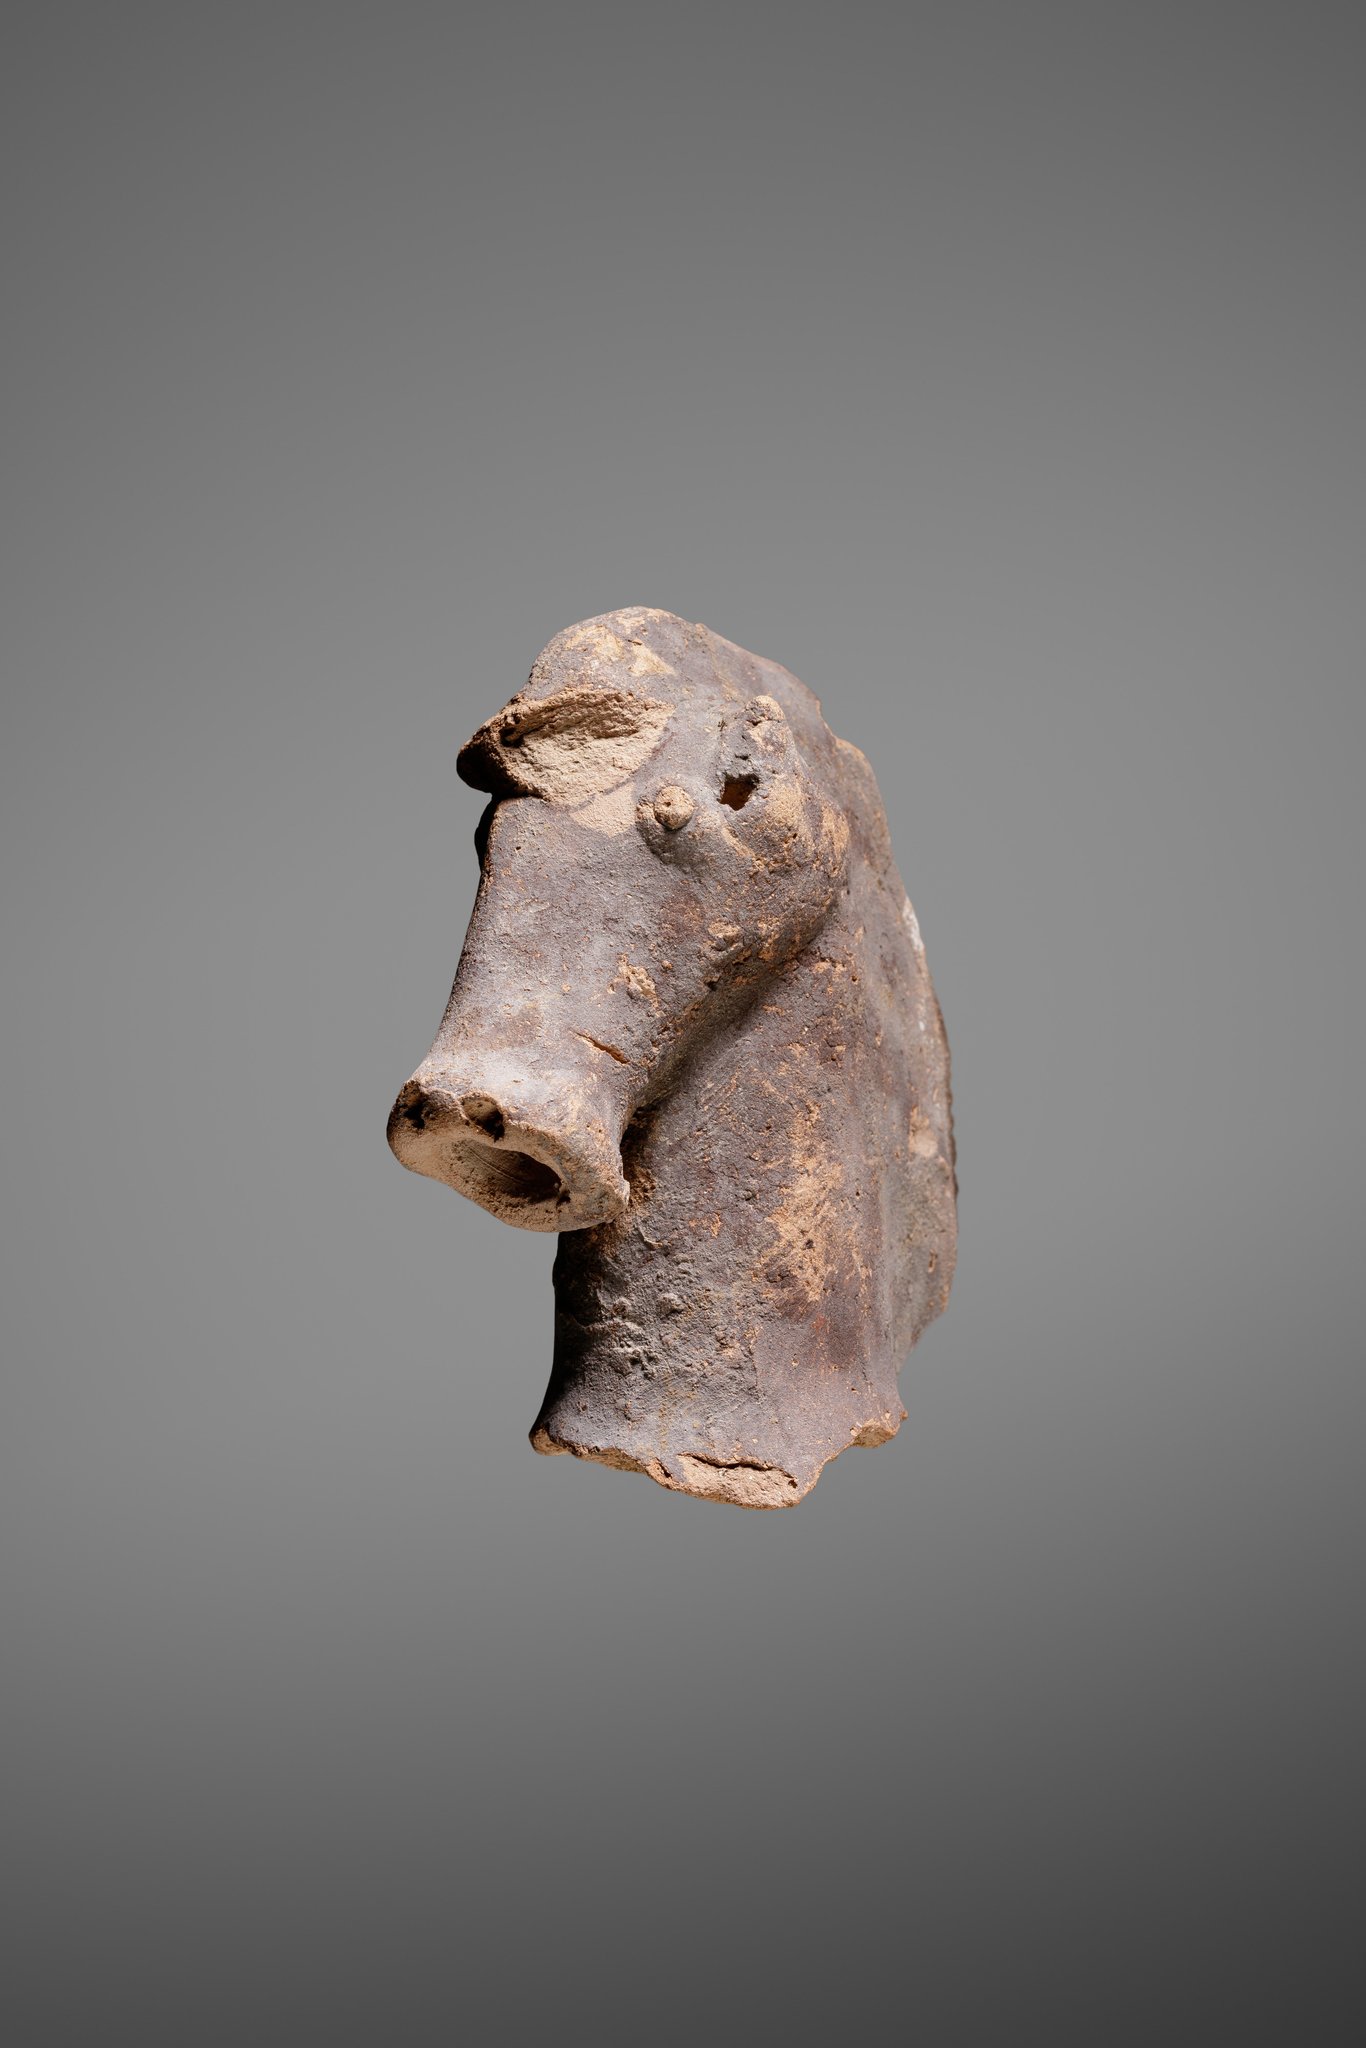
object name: figurine, horse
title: Head from a figure of a horse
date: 306-30 BCE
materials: paint, pottery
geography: egypt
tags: horses